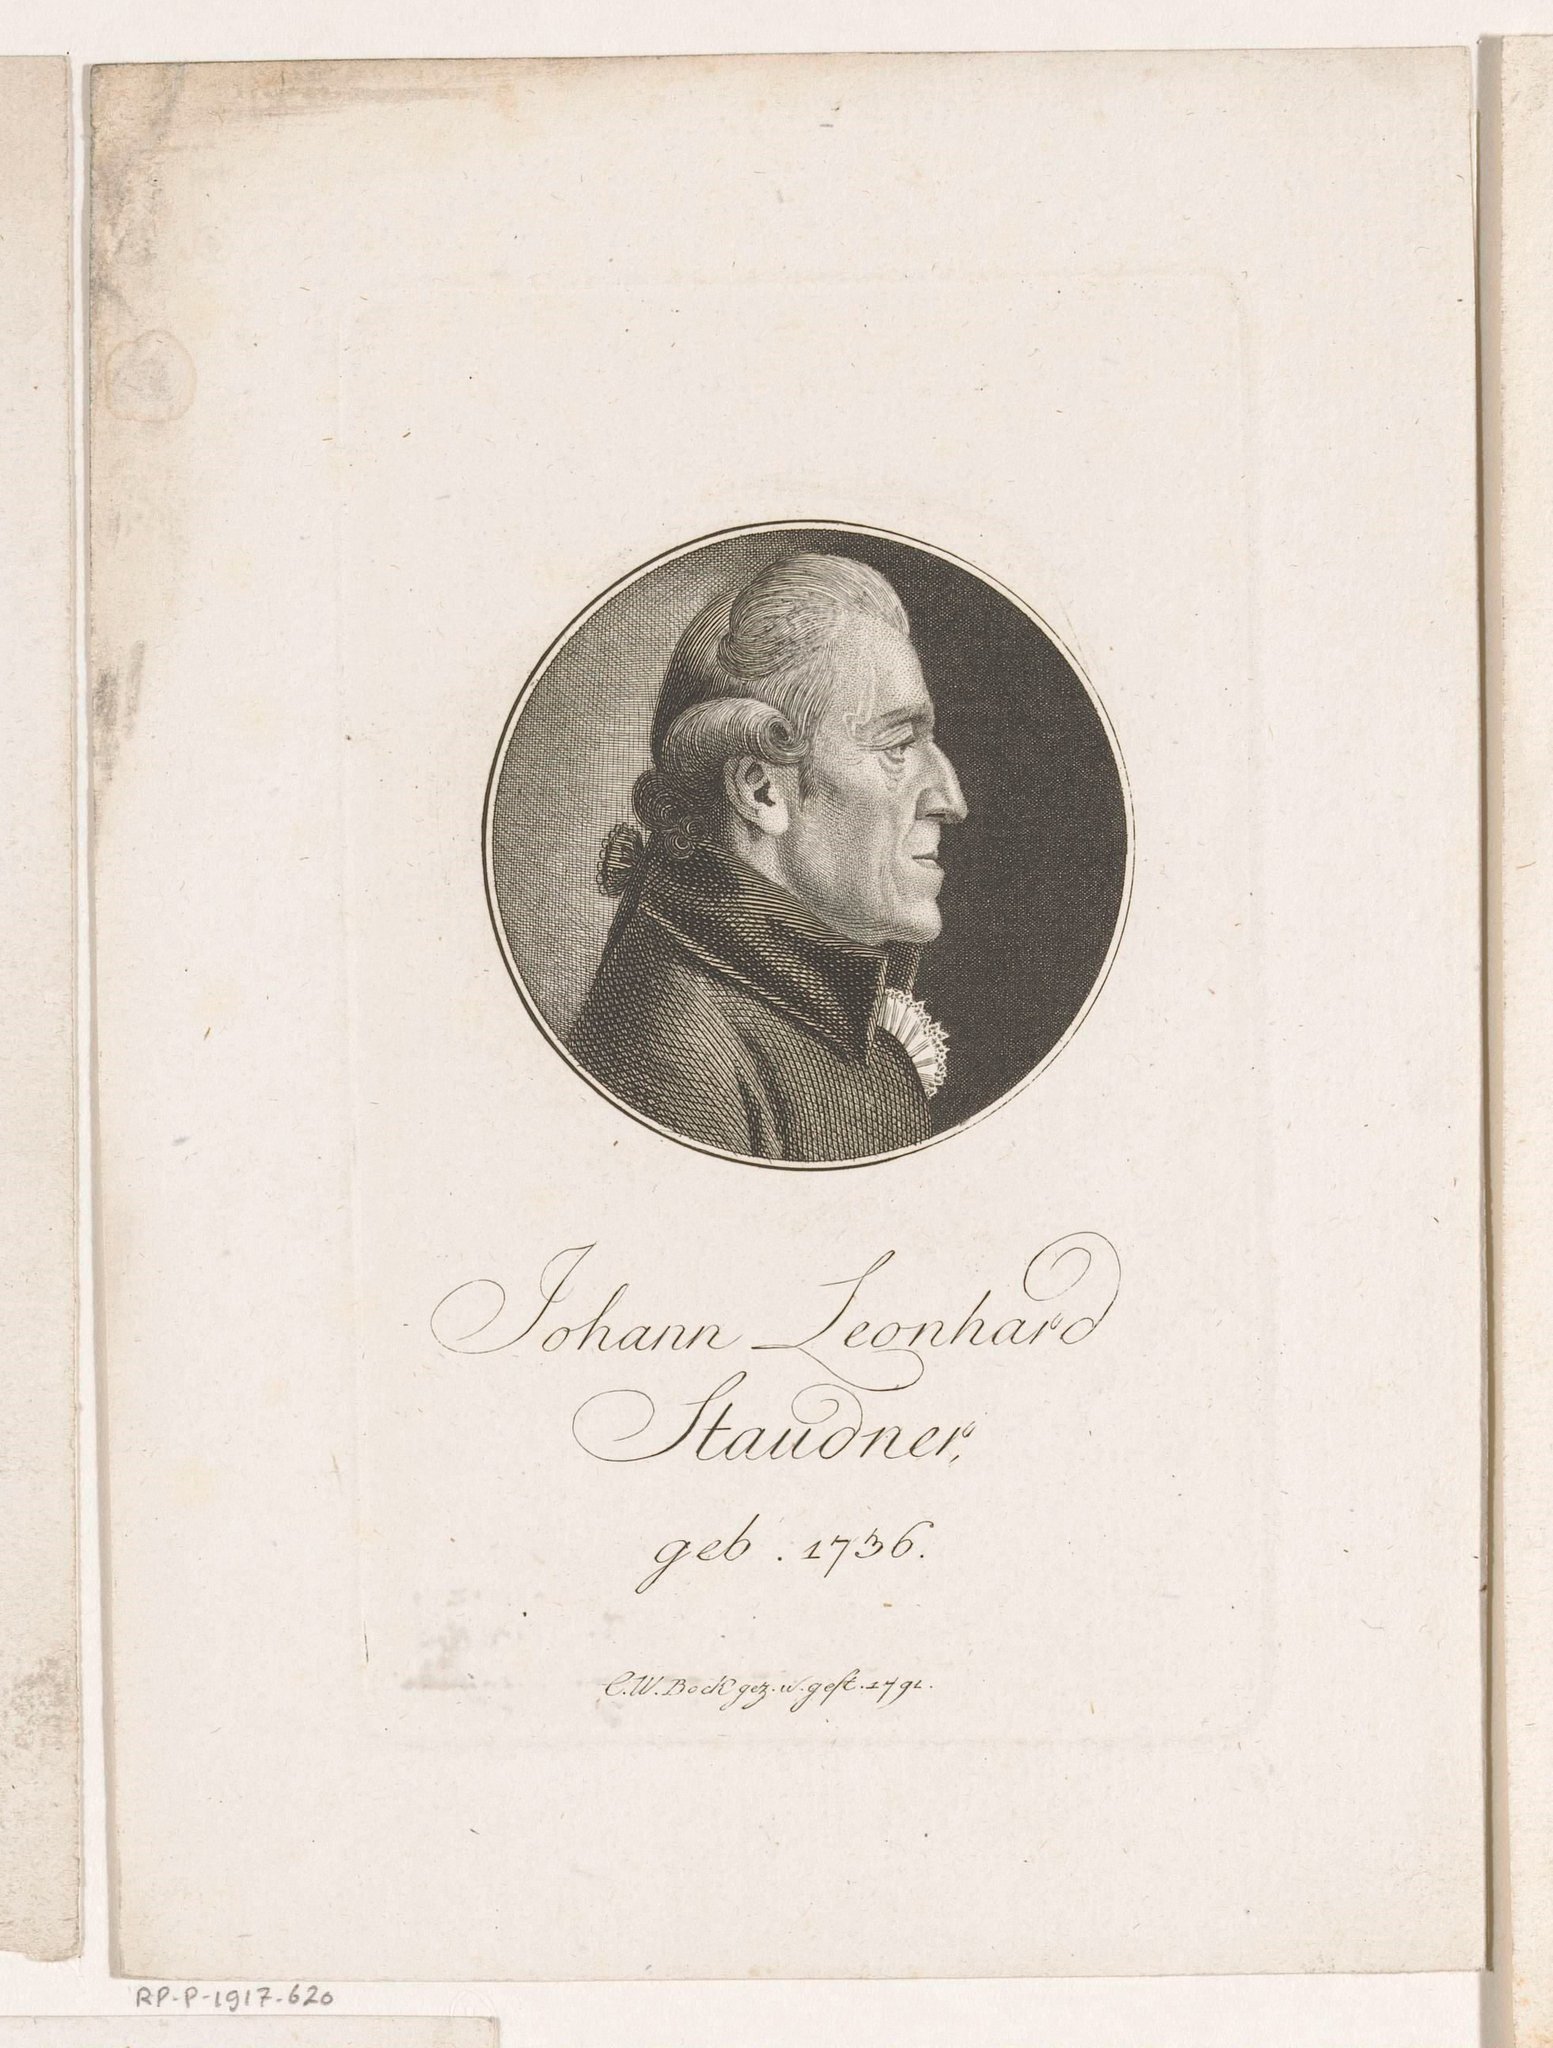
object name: print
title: Portret van Johann Leonhard Staudner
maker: christoph wilhelm bock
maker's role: print maker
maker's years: 1755-1836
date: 1791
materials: paper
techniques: engraving, etching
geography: nuremberg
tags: historical persons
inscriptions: collector's mark: Lugt 2228